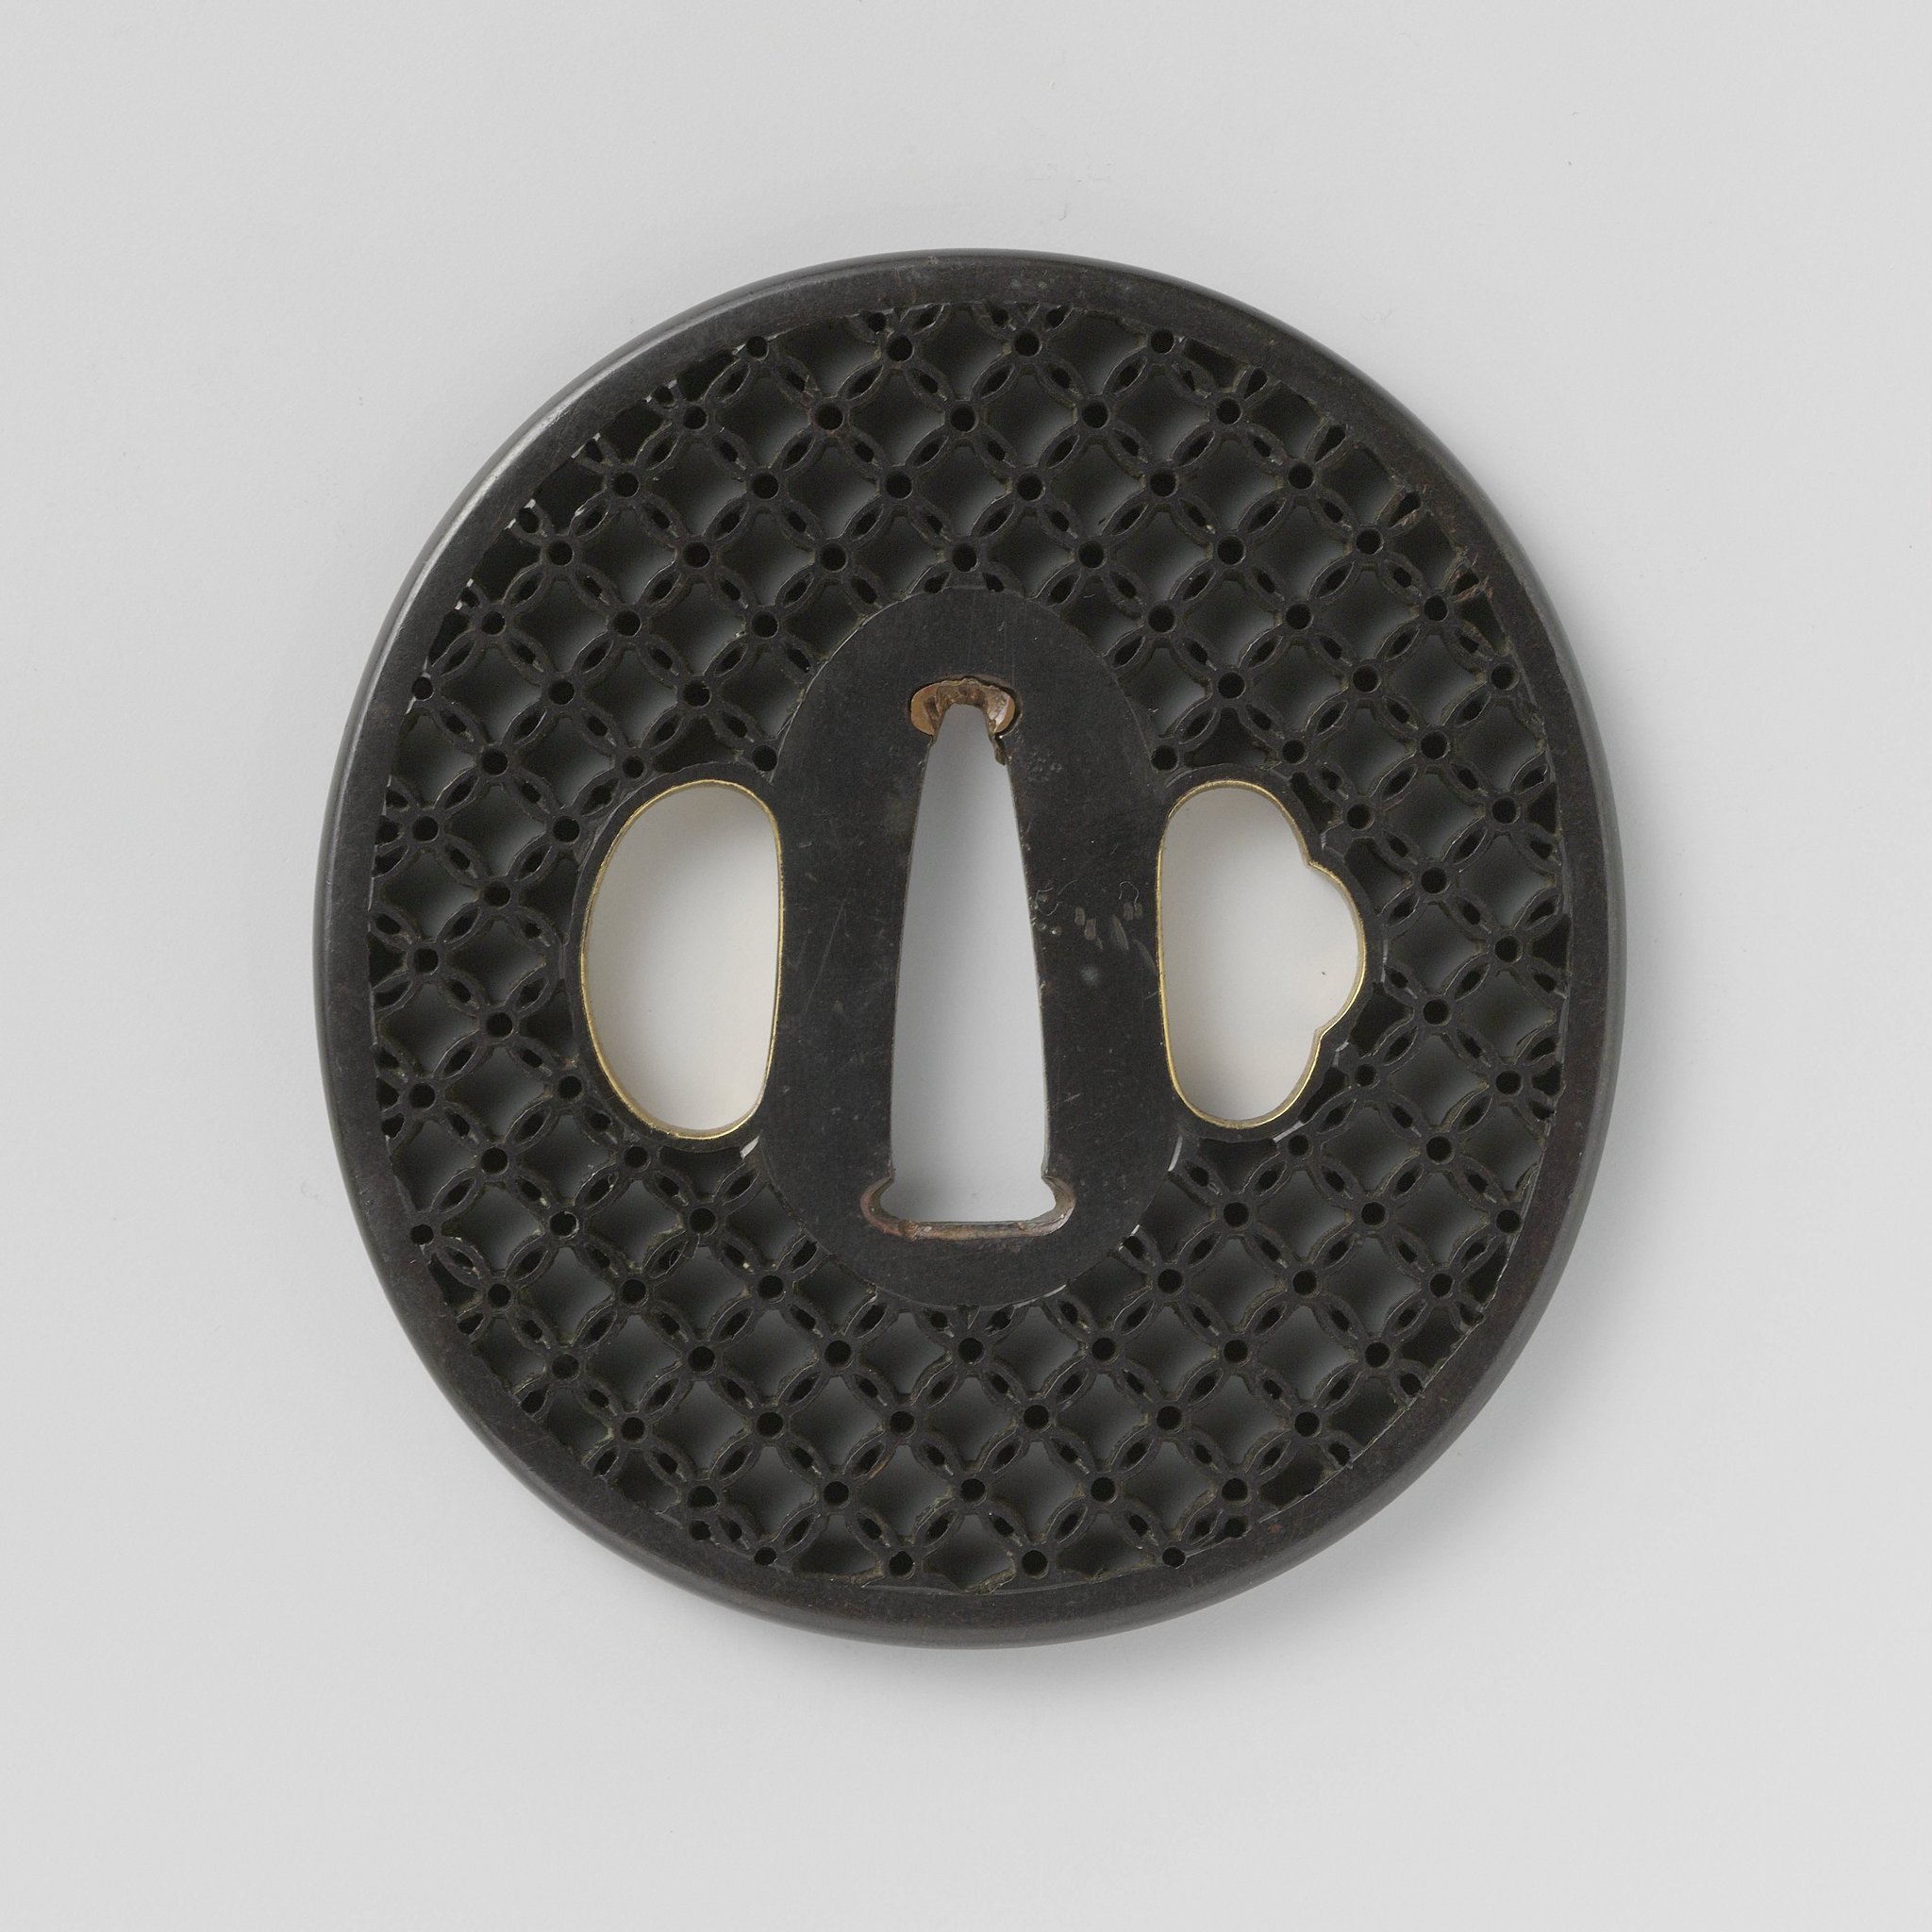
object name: tsuba, zwaardstootplaat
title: Hand guard with circle motif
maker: Anonymous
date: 1750-1850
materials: gold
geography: japan